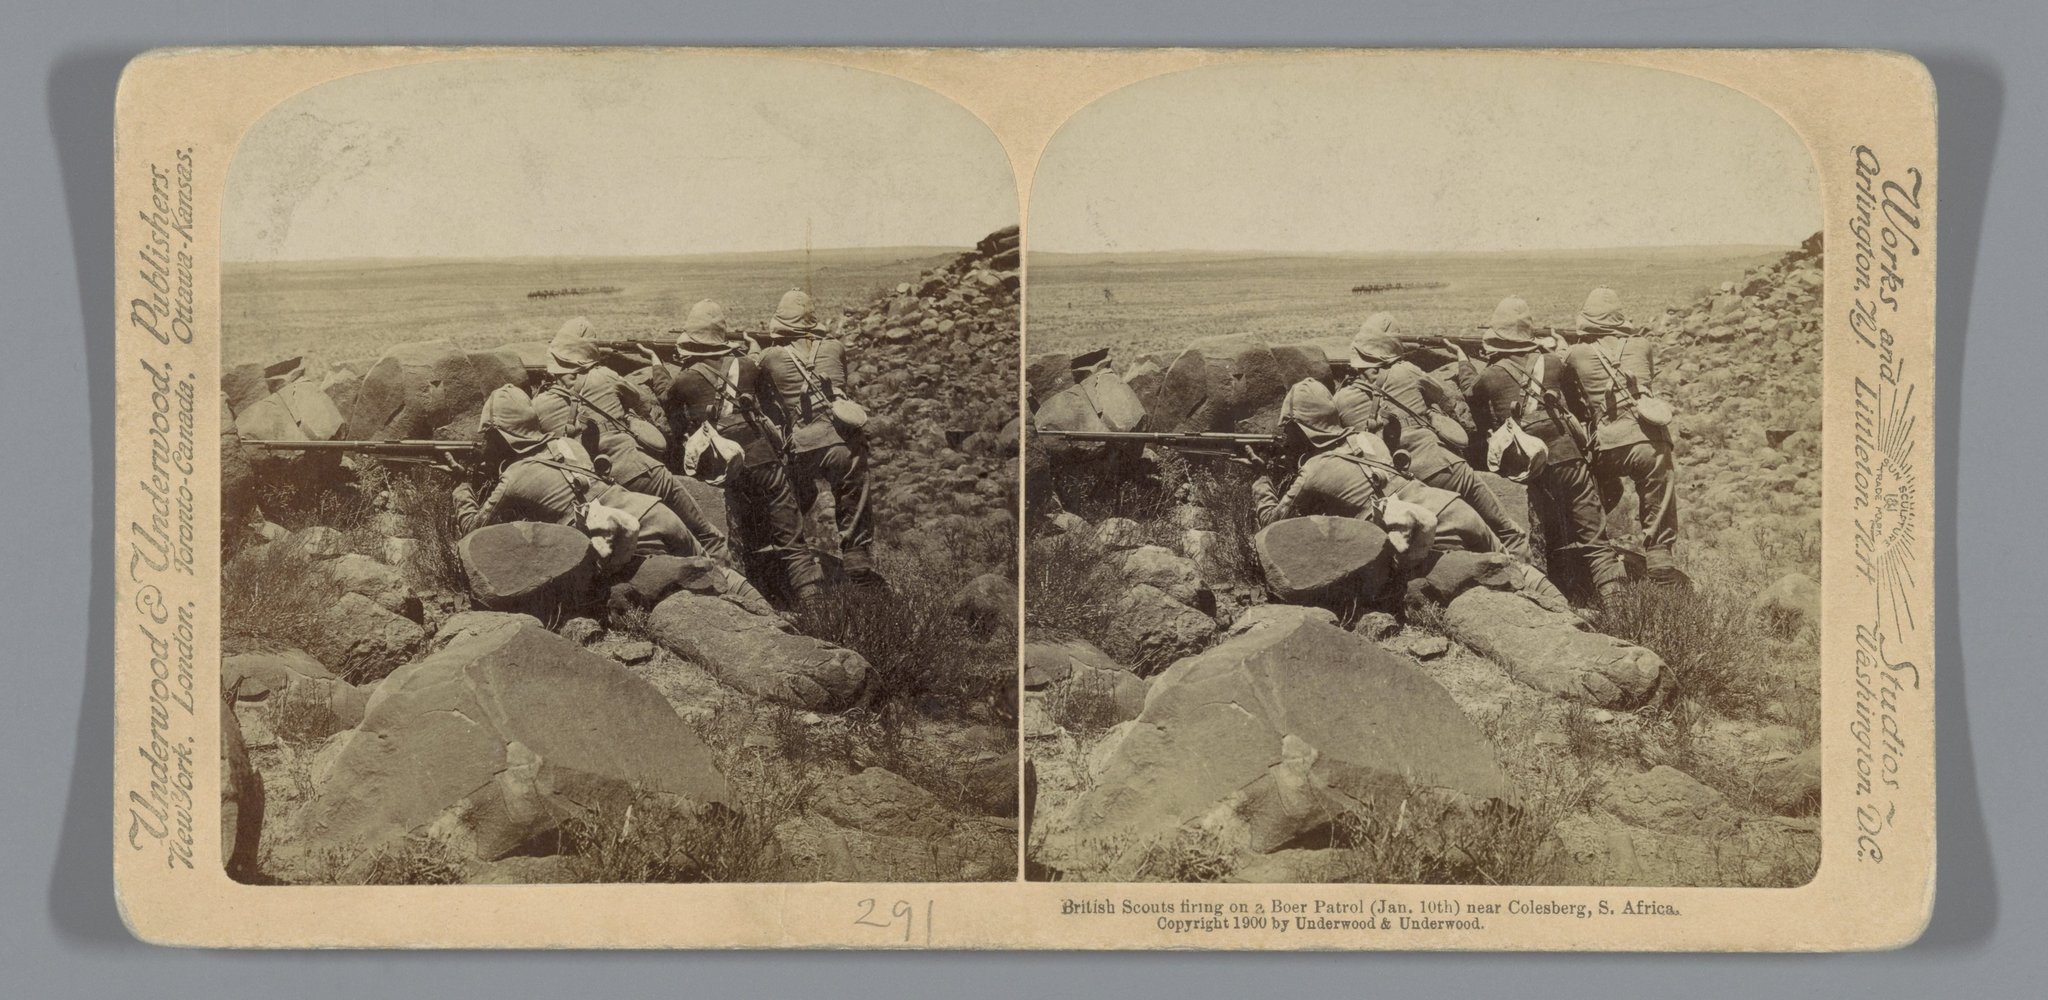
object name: stereograph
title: Britse verkenners nemen een Boerenpatrouille onder vuur in Colesberg, 10 januari 1900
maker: Anonymous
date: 1900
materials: cardboard, paper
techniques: albumen print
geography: new york city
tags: scouting, reconnaissance (military), the soldier; the soldier's life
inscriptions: inscription, copyright notice: ‘Copyright 1900 by Underwood & Underwood.’, inscription: ‘Works and Studios ~/ Arlington, N.J. Littleton, N.H. Washington, D.C.’, number: ‘291’